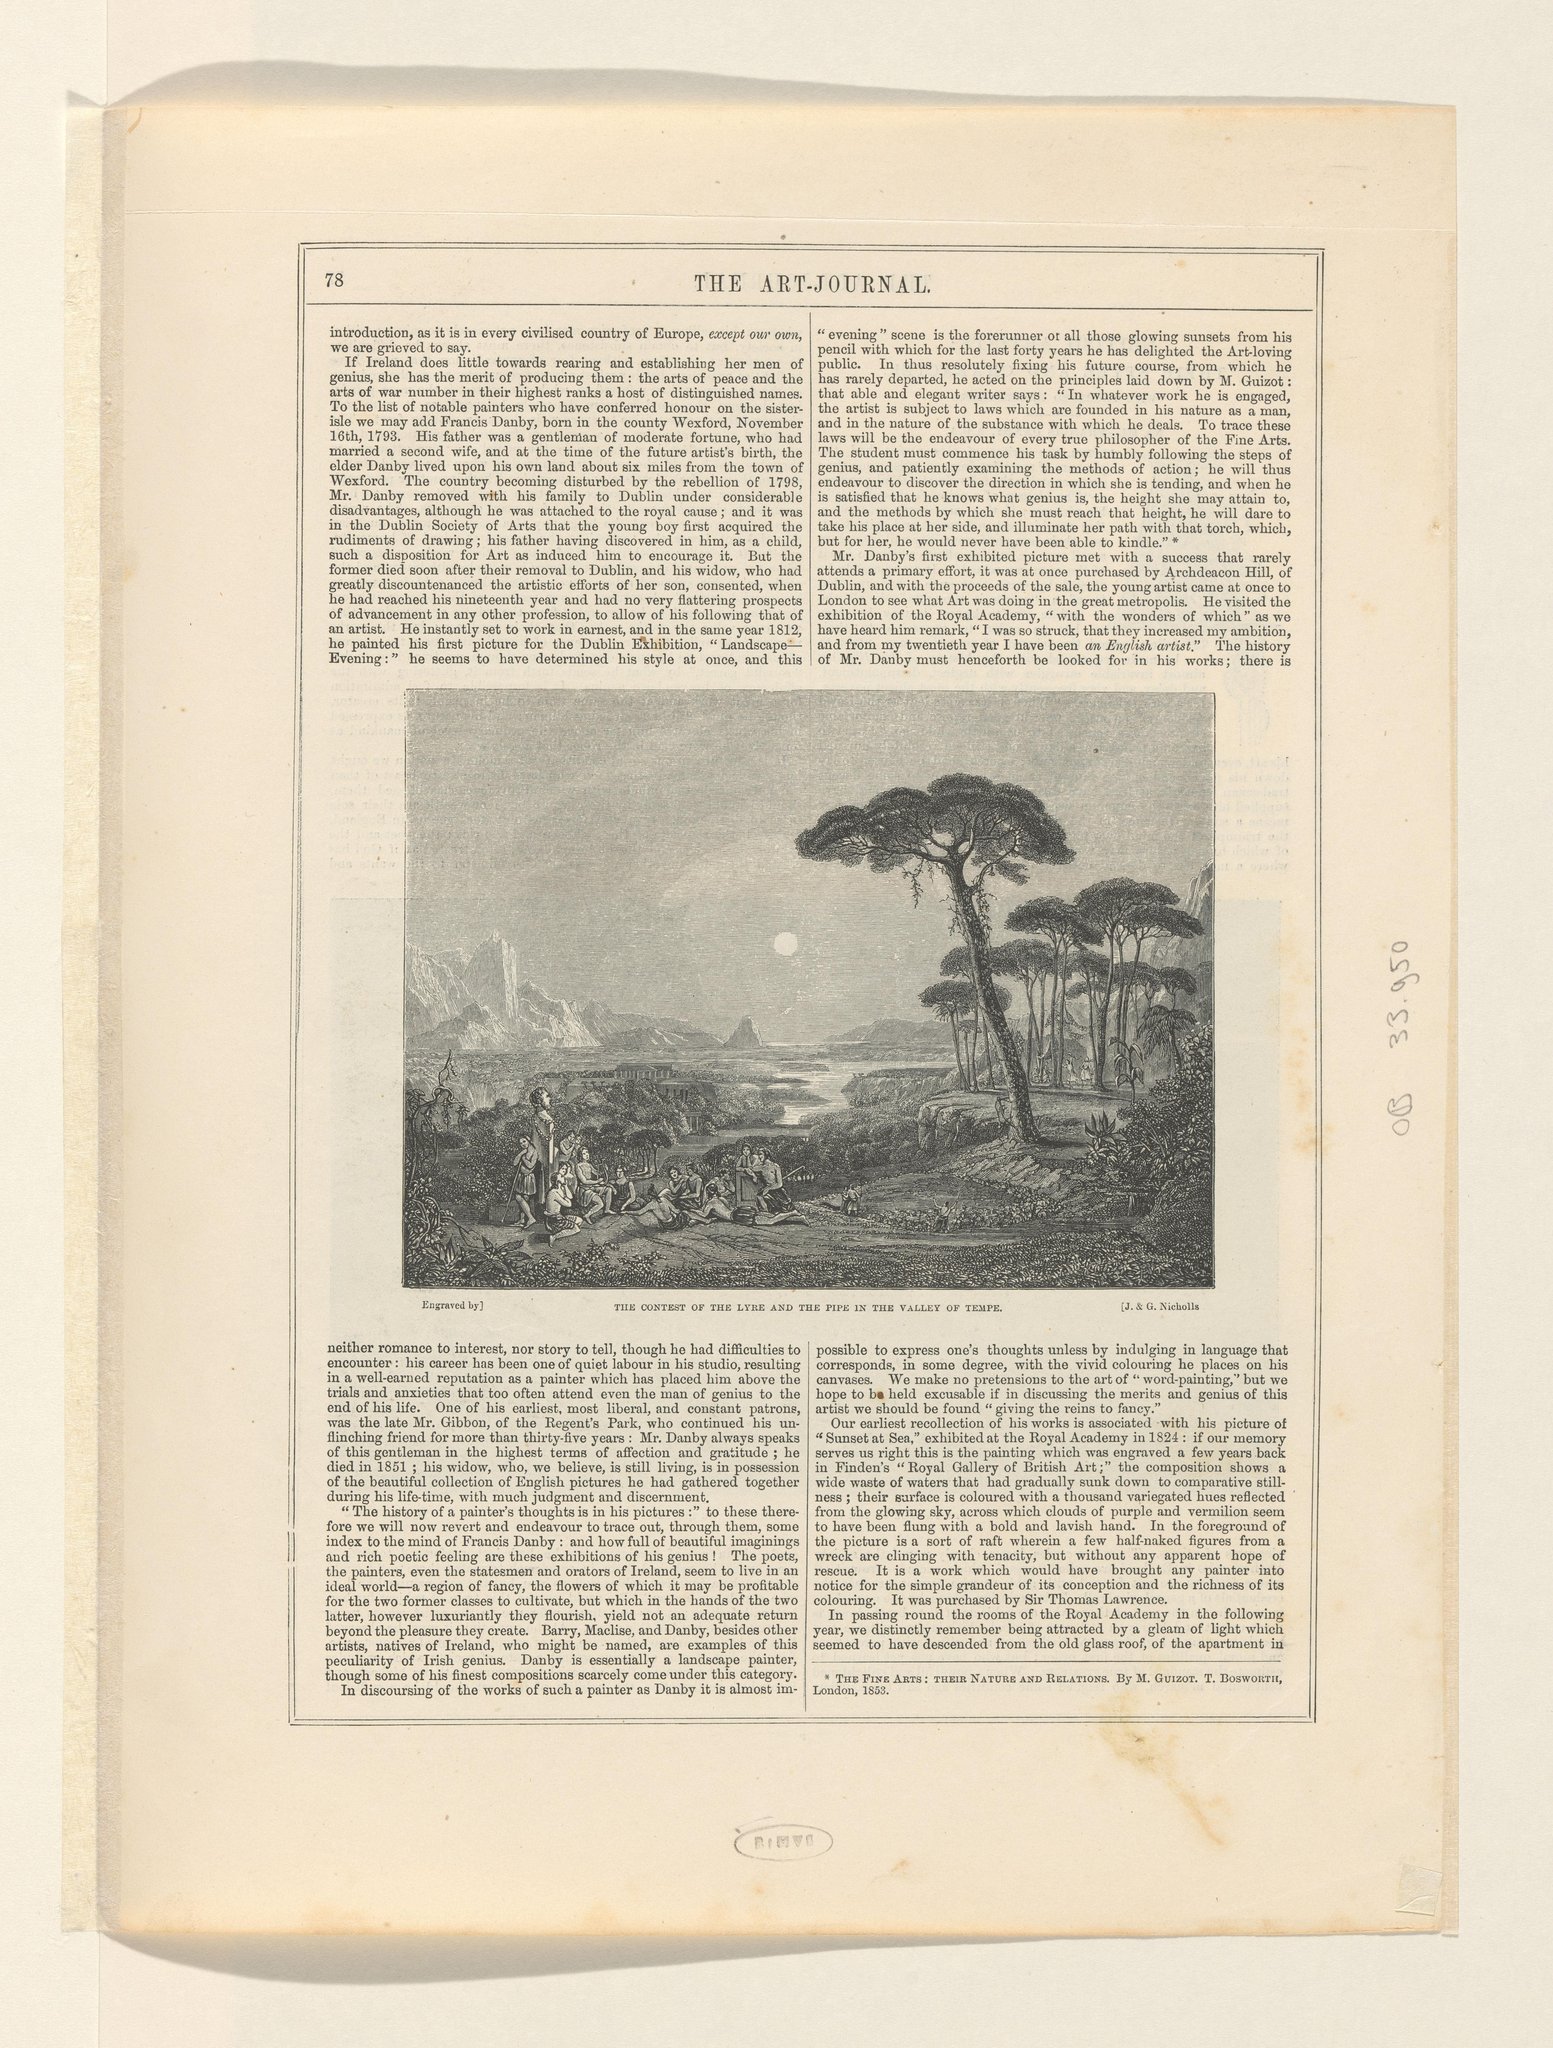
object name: print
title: Muzikaal gezelschap in het Tempedal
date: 1855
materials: paper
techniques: letterpress printing, engraving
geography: london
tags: small group of musicians, chamber orchestra, jazz band, dale, valley (+ landscape with figures, staffage), competition, art contest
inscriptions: collector's mark: Lugt 2228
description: Prent uit: The Art Journal (1855), 1855, p. 78.